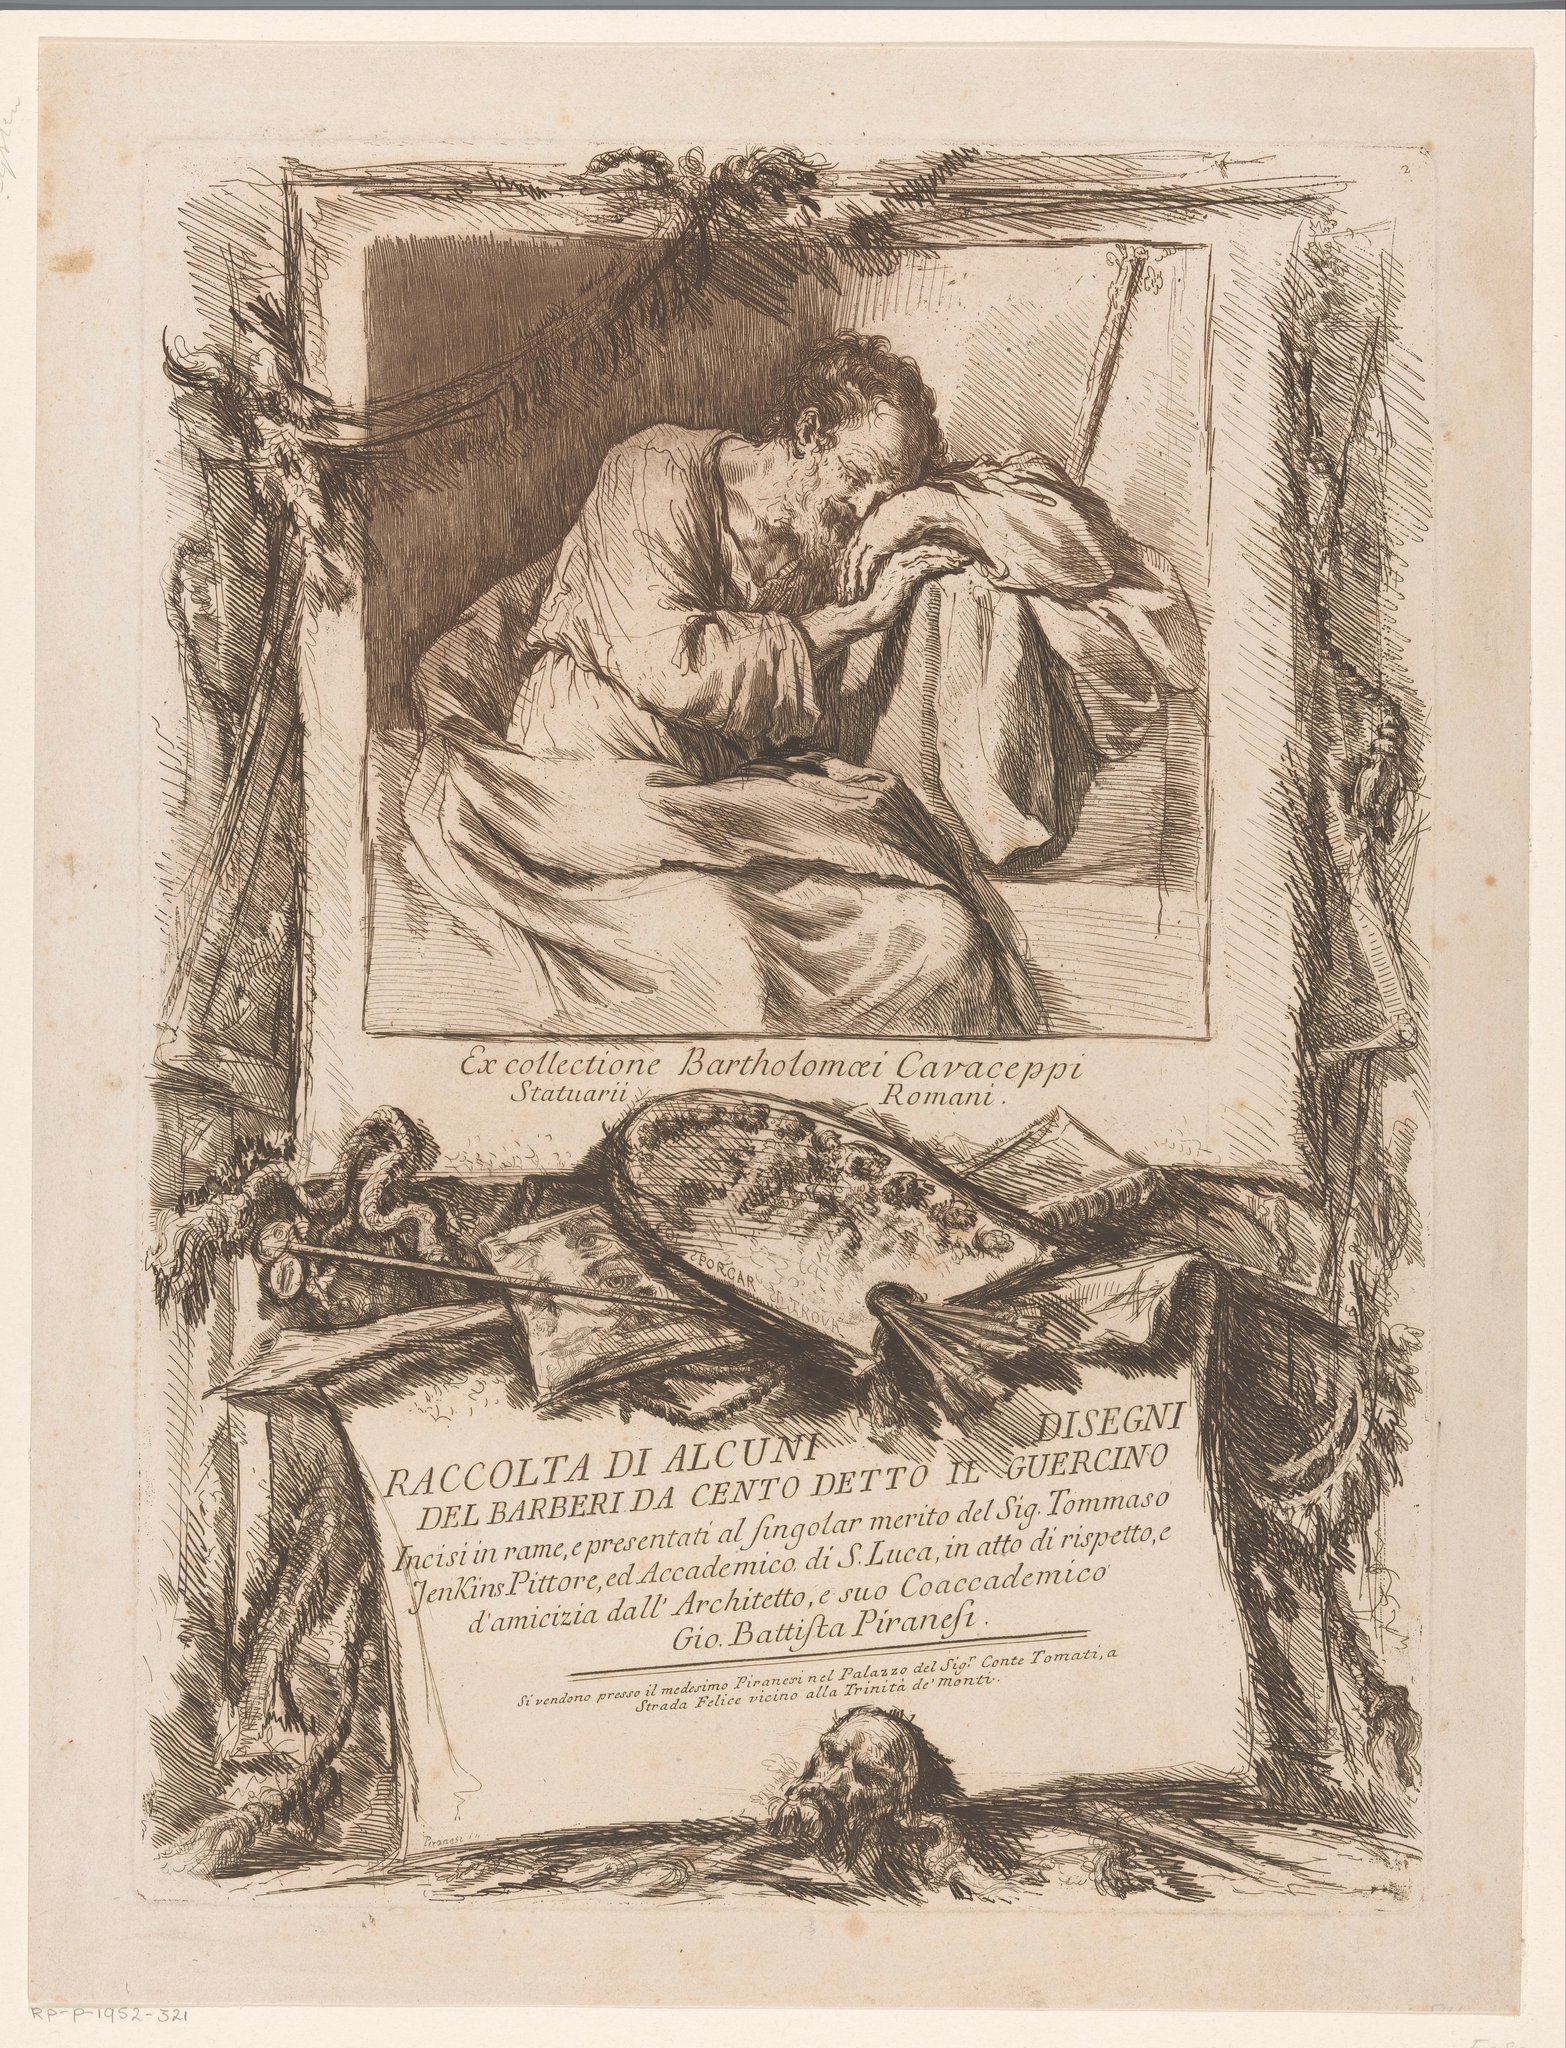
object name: print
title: Verzameling van enige tekeningen door Guercino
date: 1764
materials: paper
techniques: etching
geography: italy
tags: drawing, sketch, book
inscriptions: collector's mark: Lugt 2228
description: Deze prent maakt deel uit van de serie 'Raccolta di alcuni disegni del Barbieri da Cento detto il Guercino' met prenten naar tekeningen door Guercino en andere kunstenaars. De serie werd uitgegeven in 1764 en bevat naast deze titelprent drie prenten door Piranesi en prenten door andere kunstenaars.